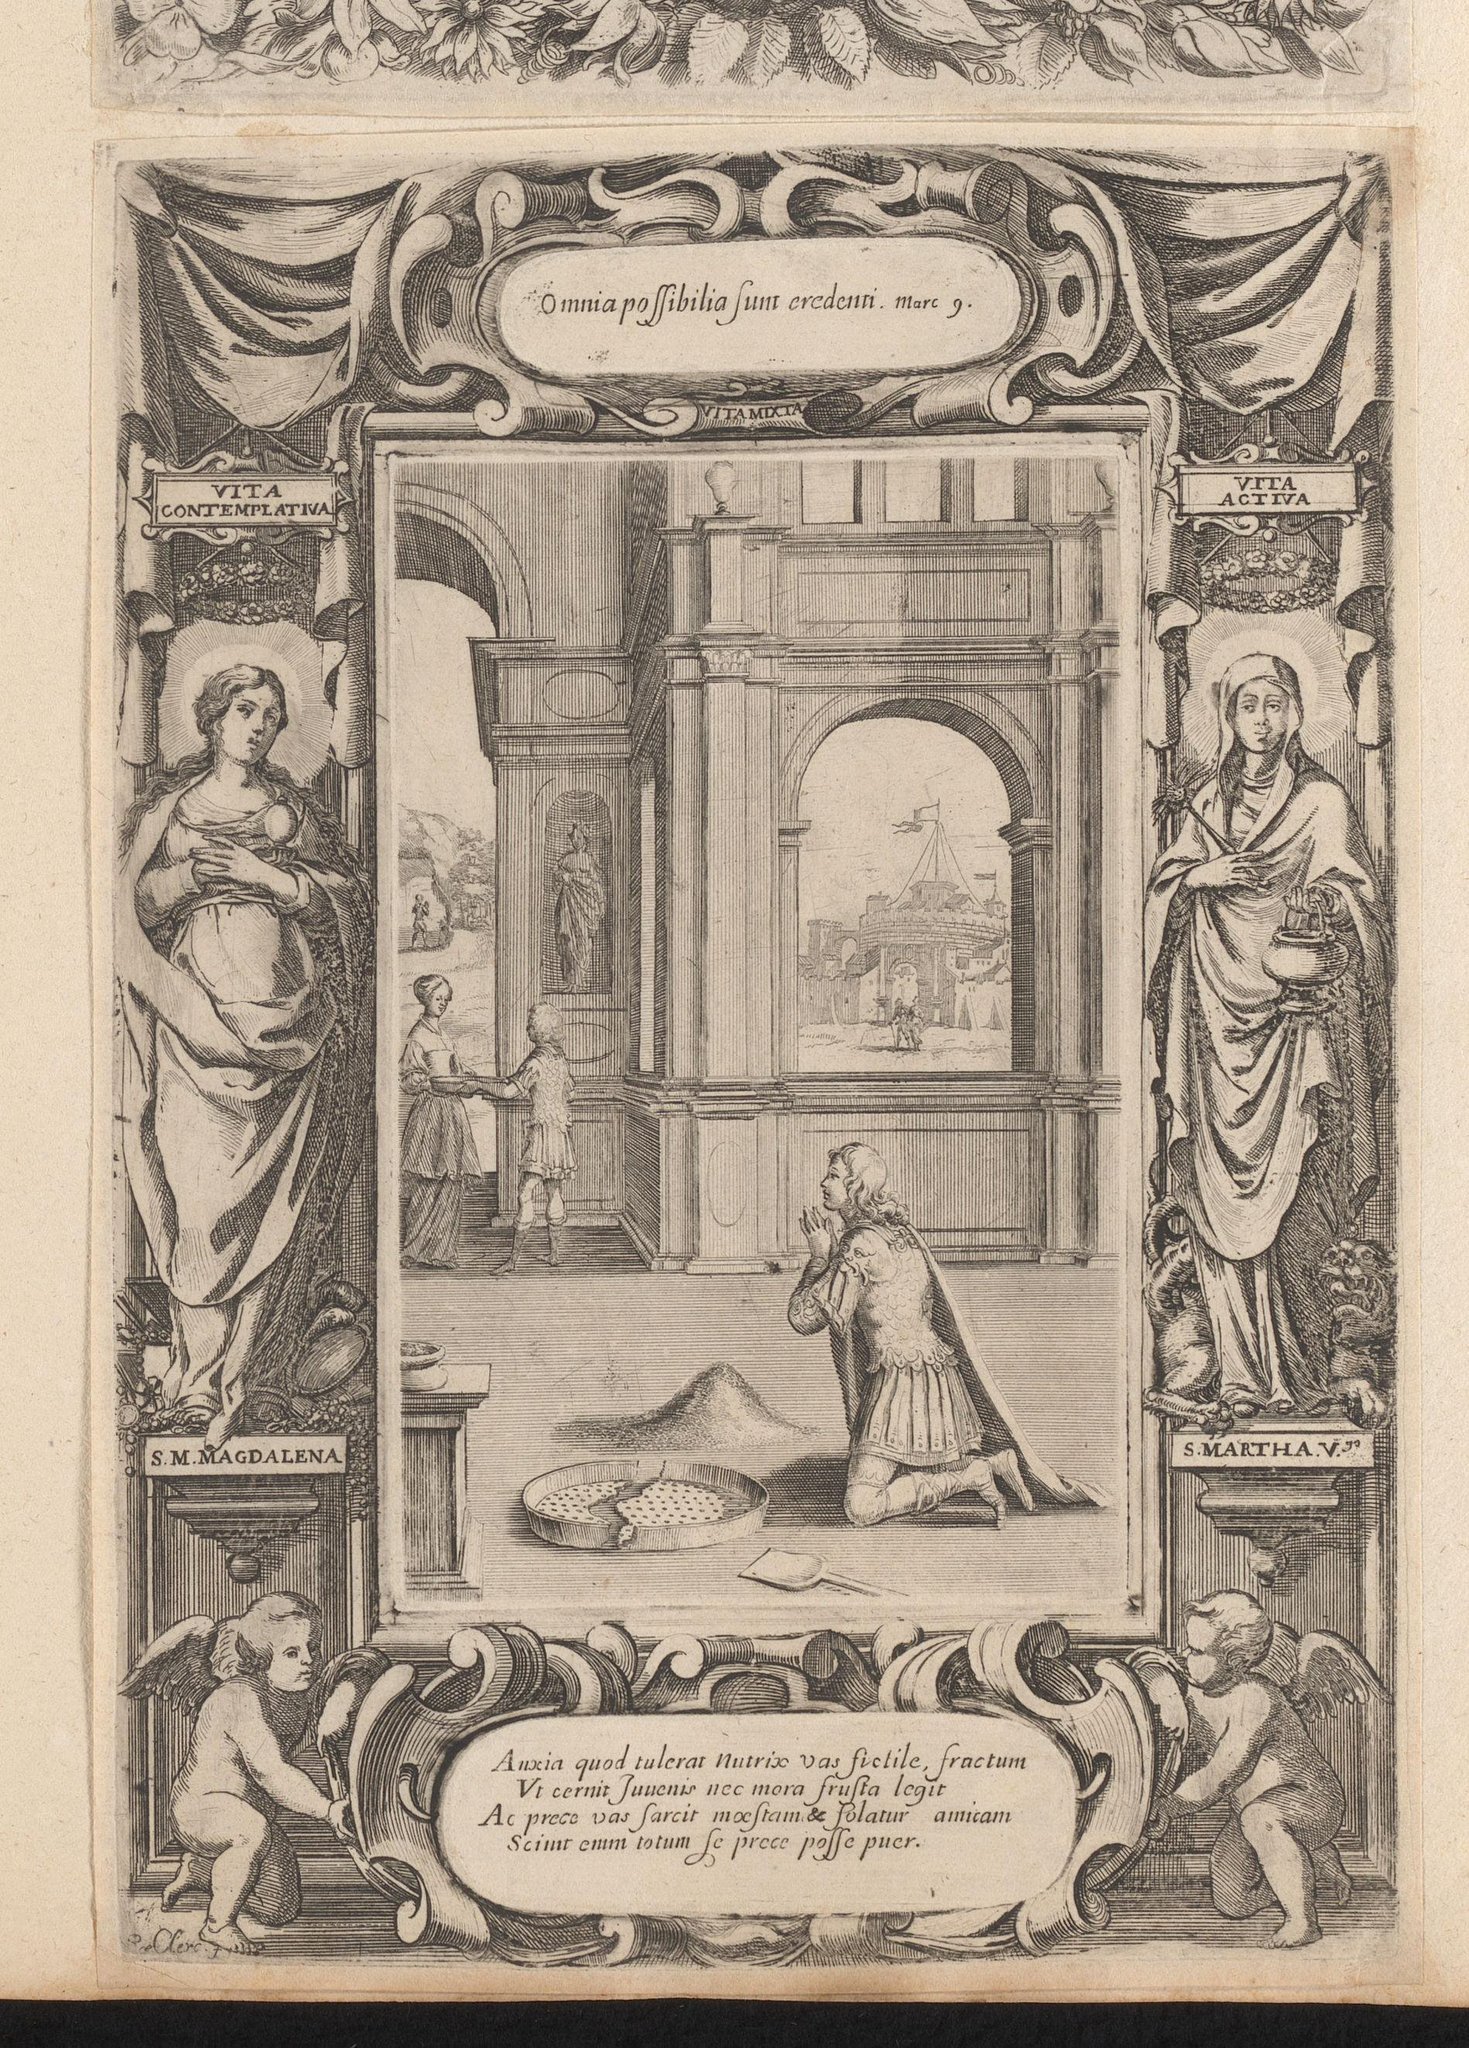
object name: album leaf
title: Vita et Miracula Sanctissimi Patris Benedecti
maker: sébastien leclerc (i)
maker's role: print maker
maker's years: 1637-1714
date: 1658-1659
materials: paper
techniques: etching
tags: st. benedict miraculously mends the broken sieve of his nurse cyrilla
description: Maakt deel uit van een serie bestaande uit 33 prenten met voorstellingen uit het leven van de Heilige Benedictus van Nursia in ornamentele cartouches, uitgegeven in 1658-1659. De prenten zijn gedrukt van drie afzonderlijke platen bestaande uit de voorstelling, de cartouche en de tekst.